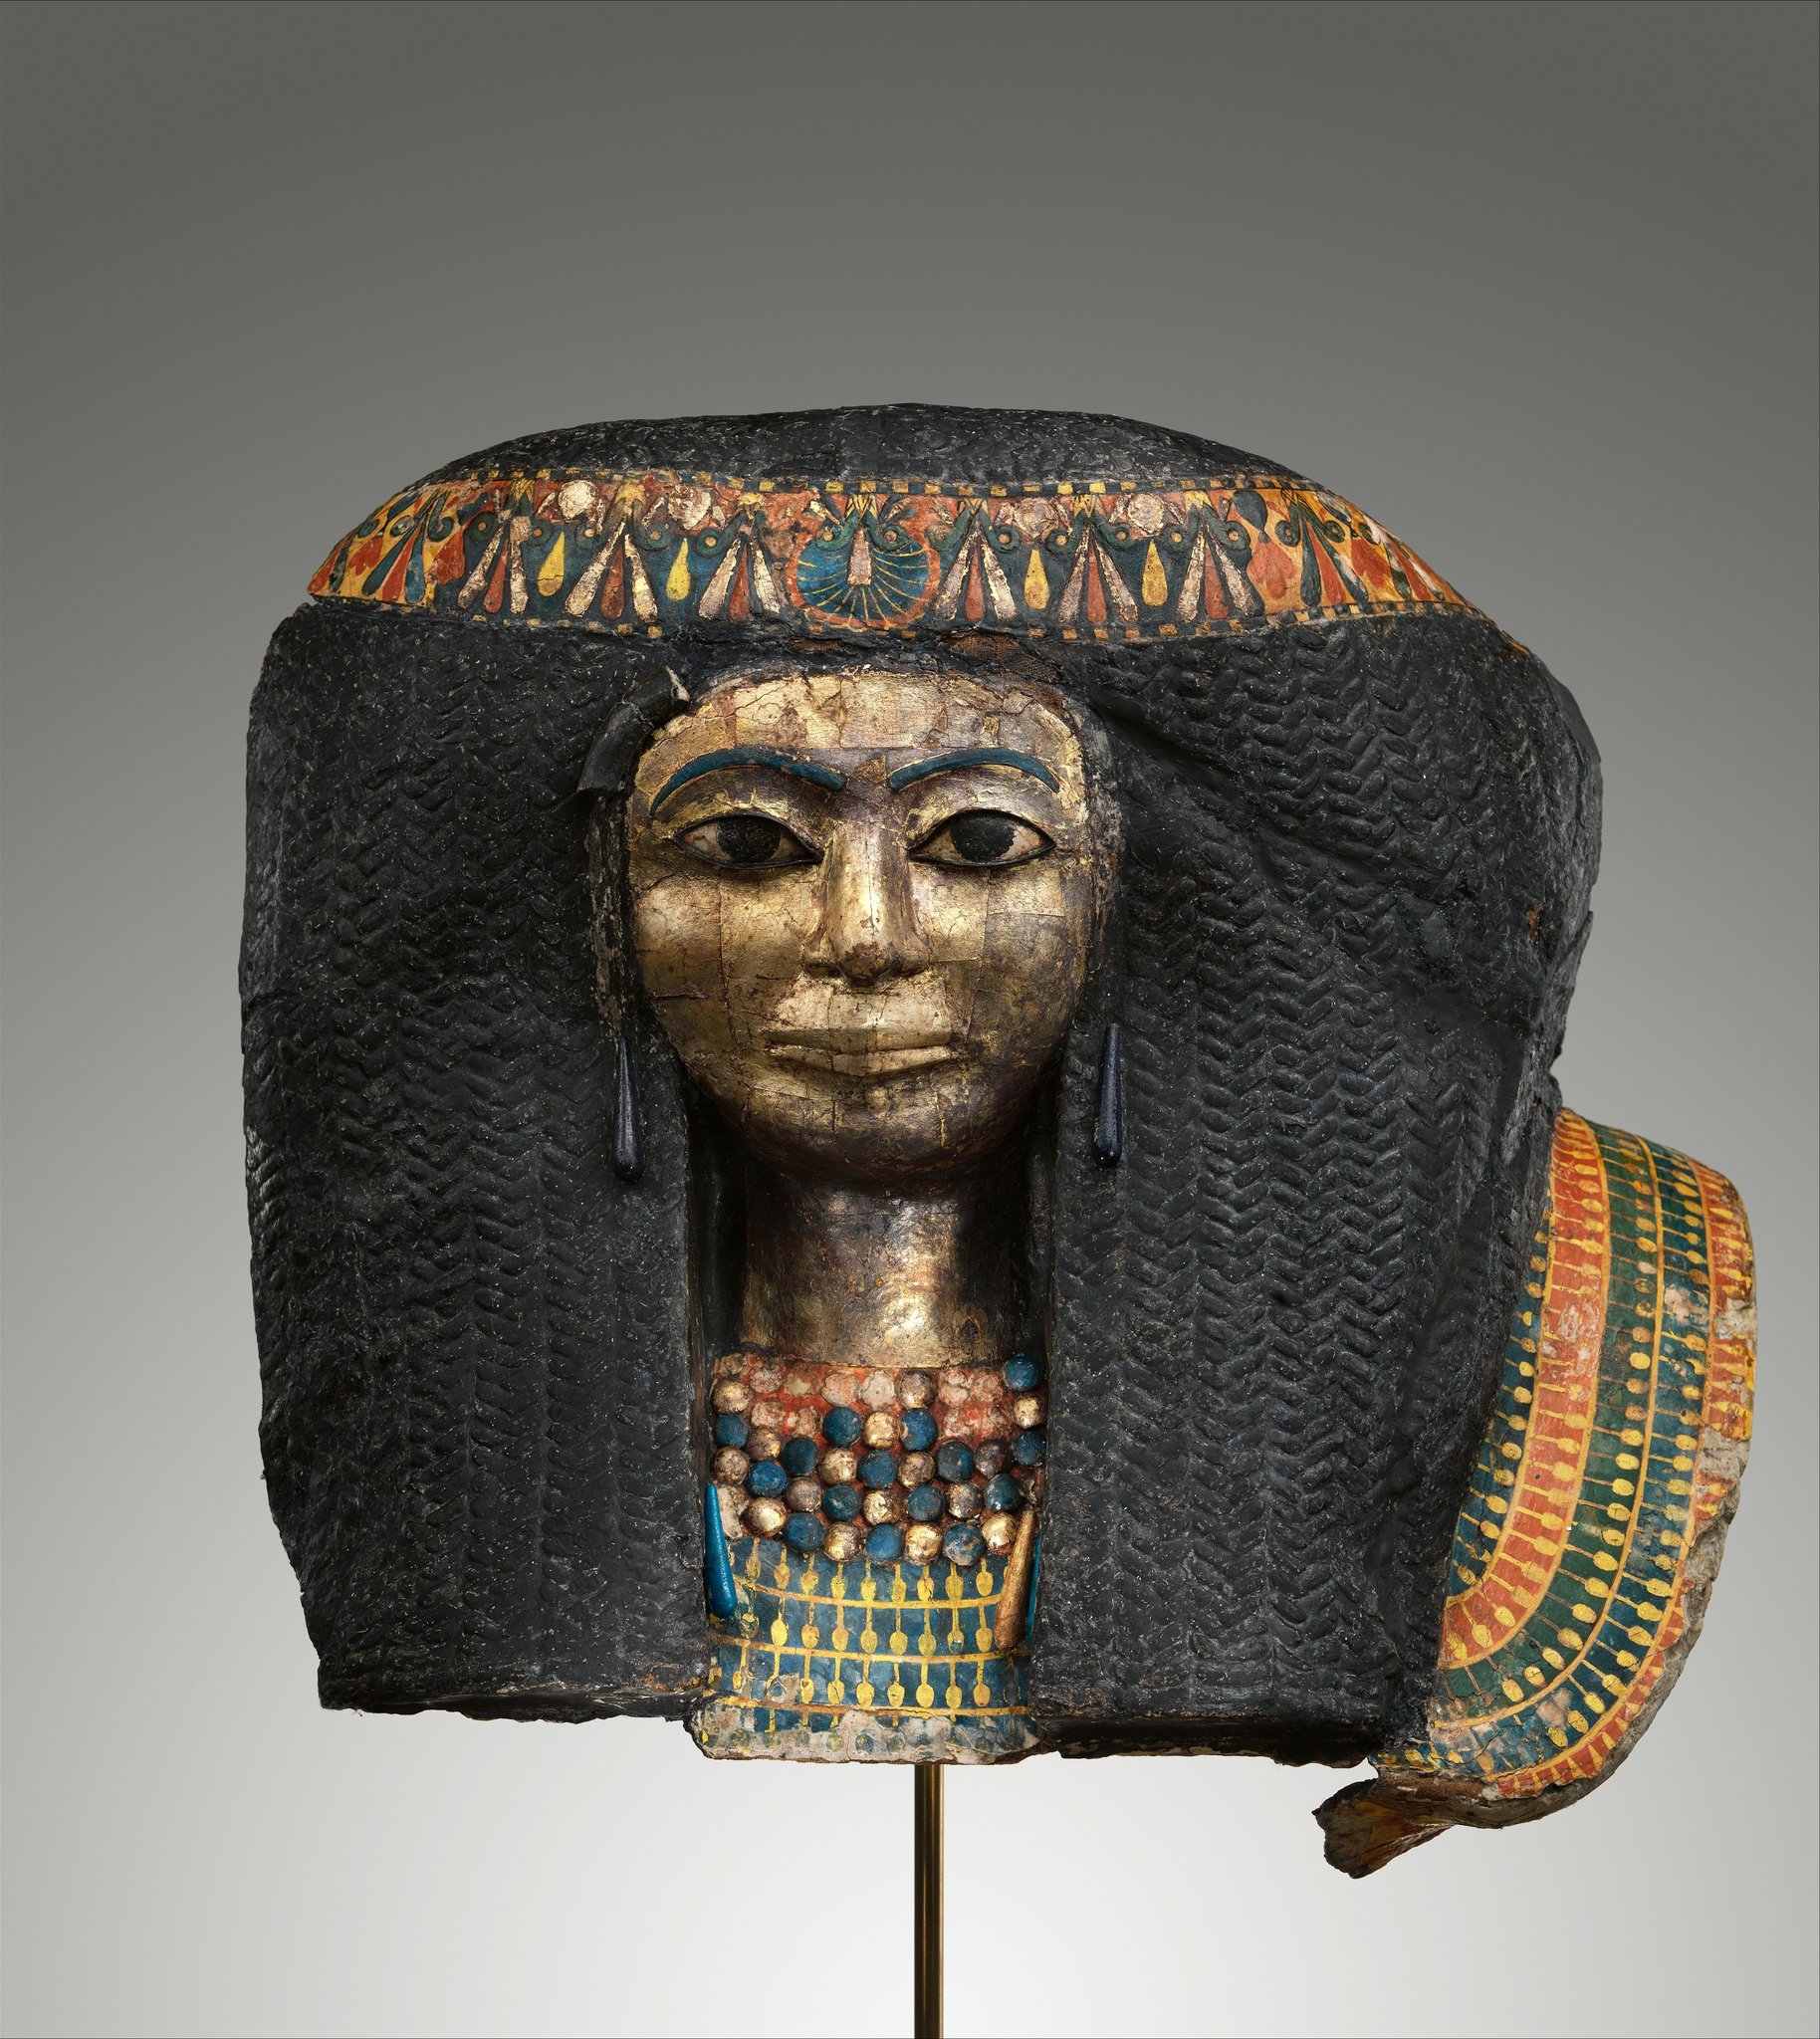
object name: mask, diadem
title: Funerary Mask of a Woman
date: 1427-1390 BCE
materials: copper alloy, faience, gesso, gold, paint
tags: masks